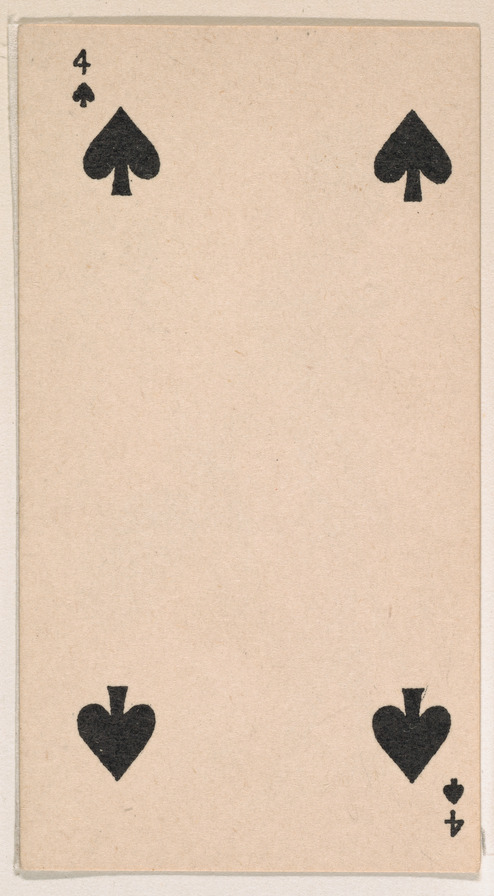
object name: print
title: Four of Spades, from the Transparent Playing Cards series (N220) issued by Kinney Bros.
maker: kinney brothers tobacco company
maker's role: publisher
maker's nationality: american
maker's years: 1869-2011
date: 1888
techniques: color lithograph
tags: playing cards